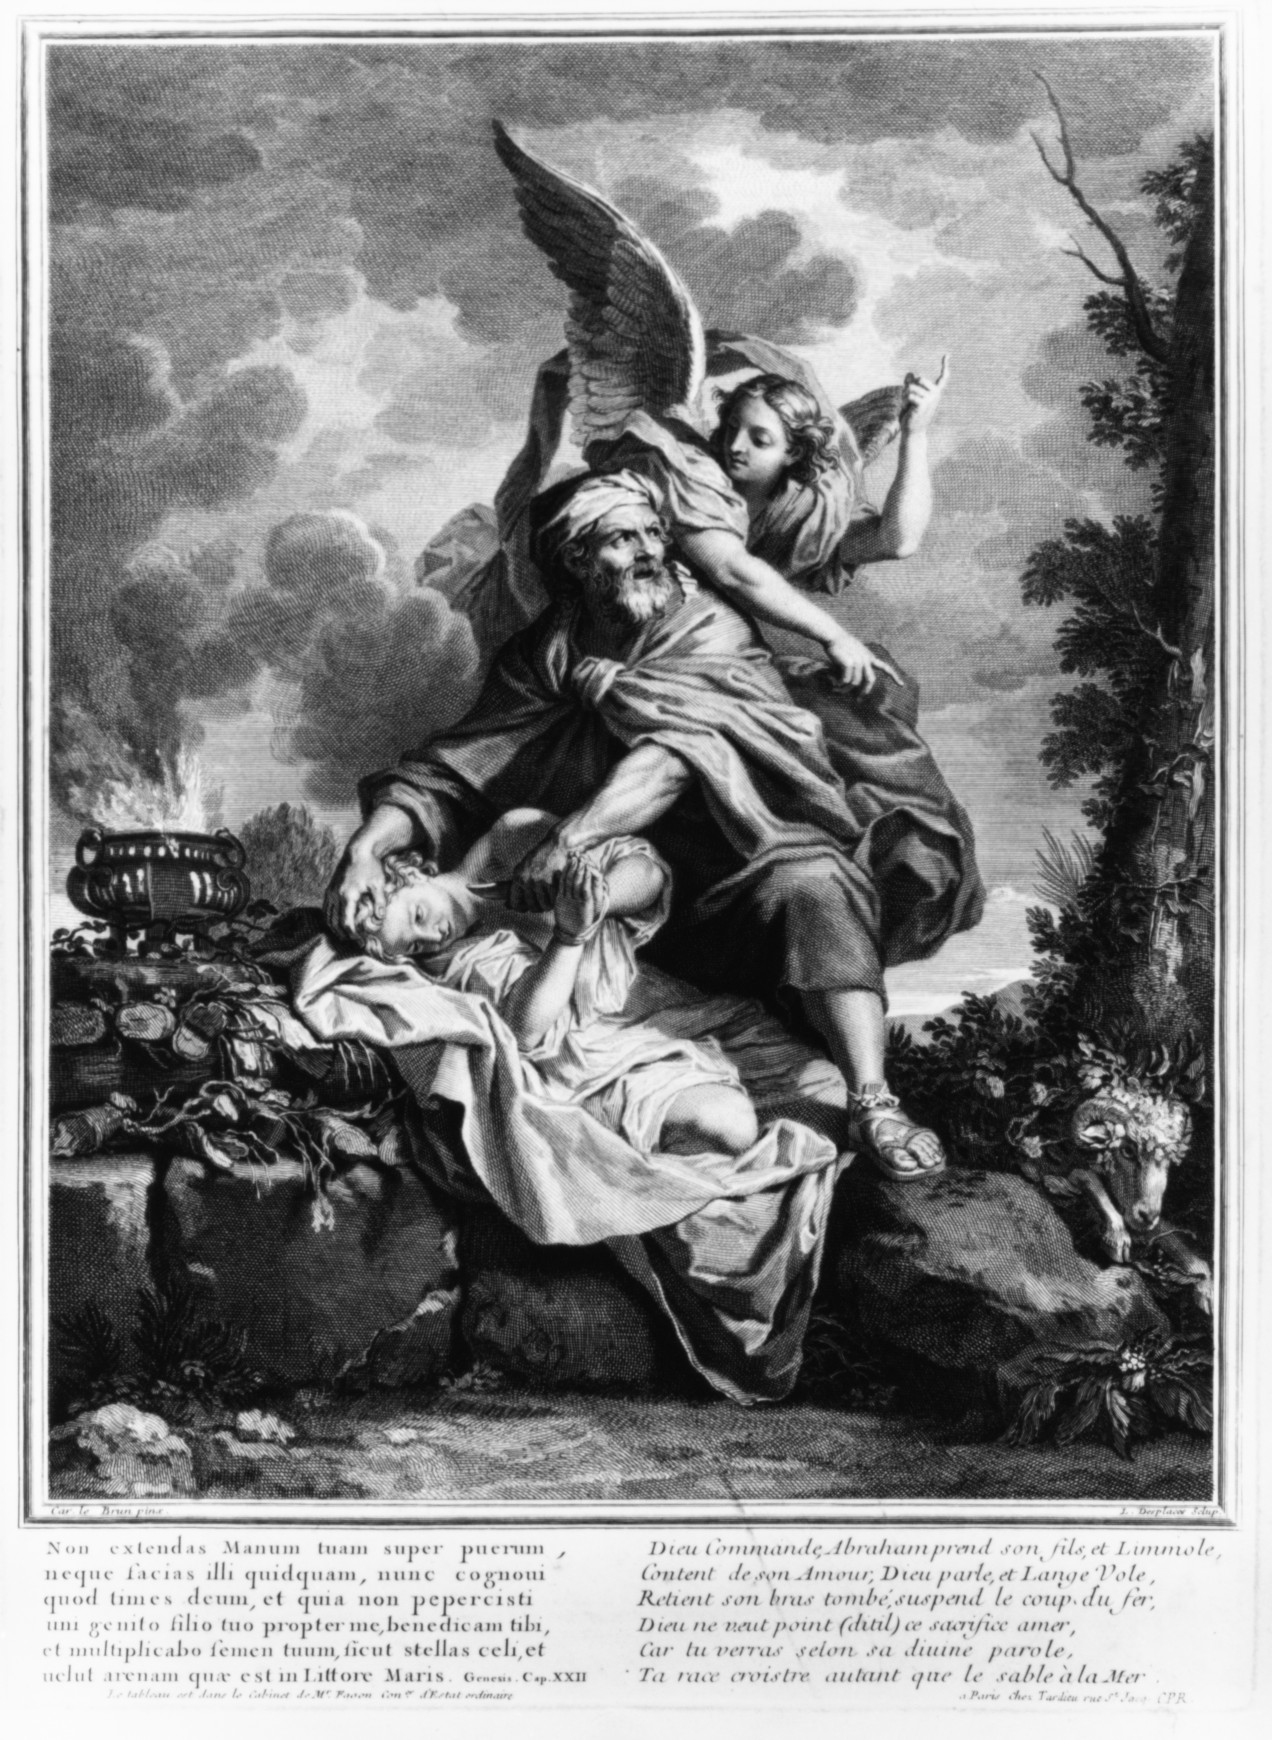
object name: print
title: The Sacrifice of Isaac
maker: louis desplaces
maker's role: artist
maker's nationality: french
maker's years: 1682-1739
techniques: engraving, etching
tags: boys,men,angels